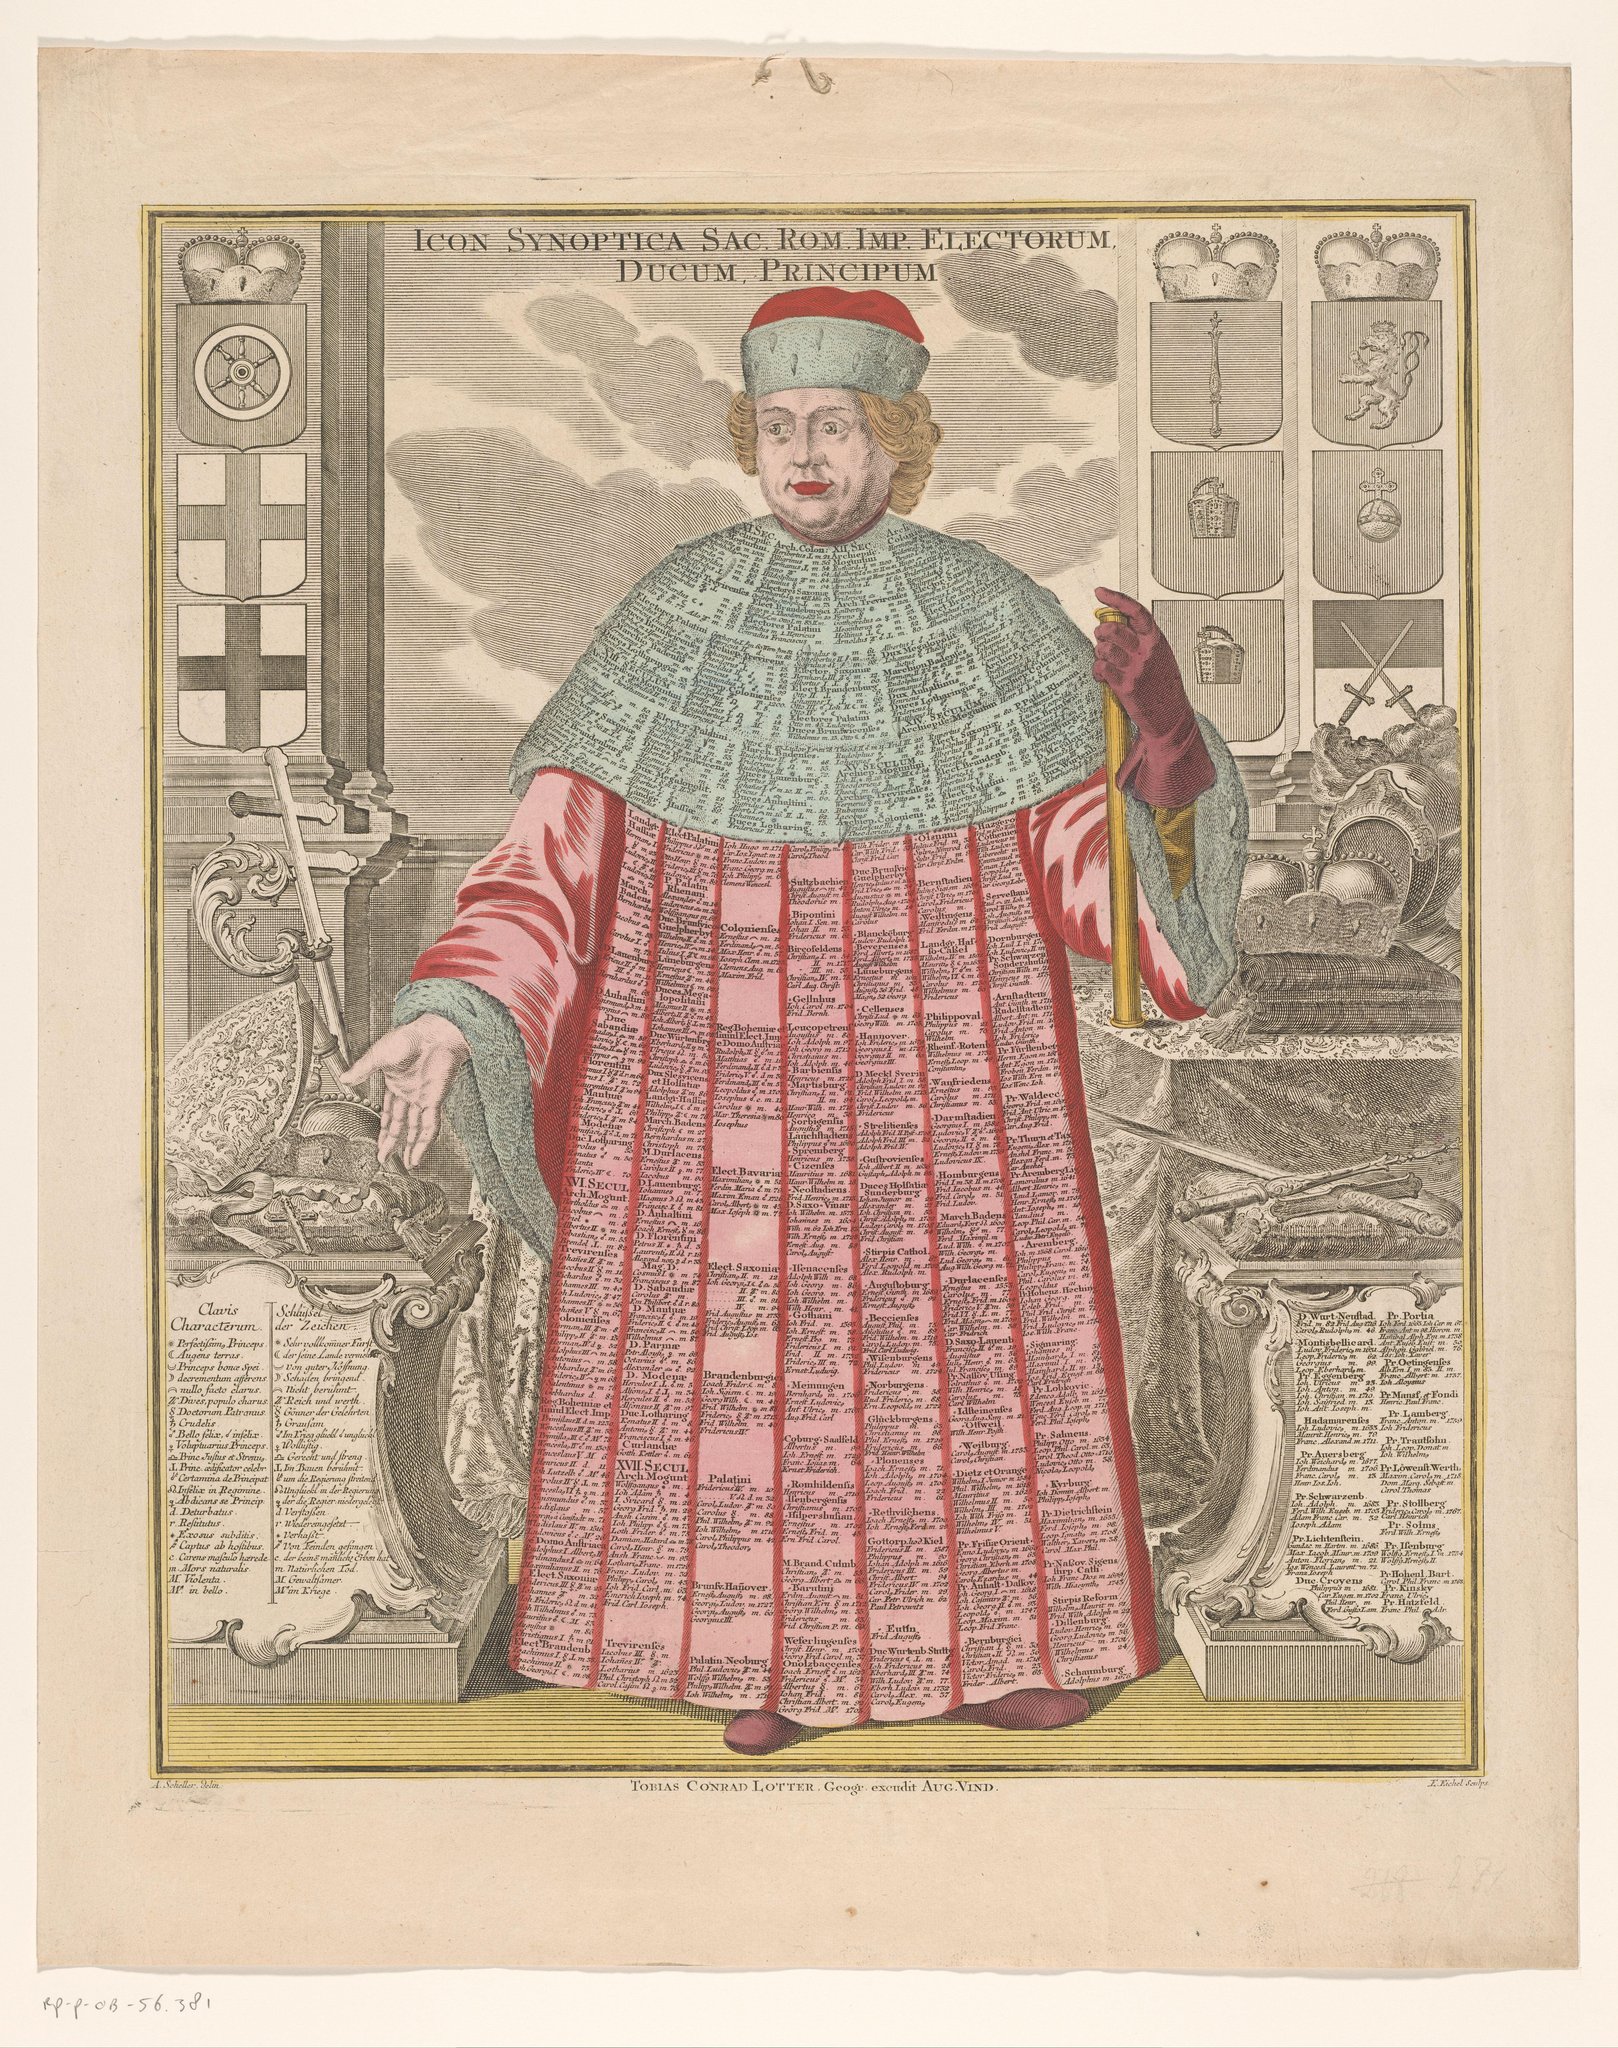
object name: print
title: Icon Synoptica Sac. Rom. Imp. Electorum, Ducum, Principum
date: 1727-1782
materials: paper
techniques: etching, hand coloring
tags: chronology, history, prince, government, the state; 'politica', 'auttorità o potestà' (ripa)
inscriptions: collector's mark: Lugt 2228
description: De tekst duidt de adellijke samenstelling van het Heilig Roomse Rijk aan, naast de figuur twee legenda's.